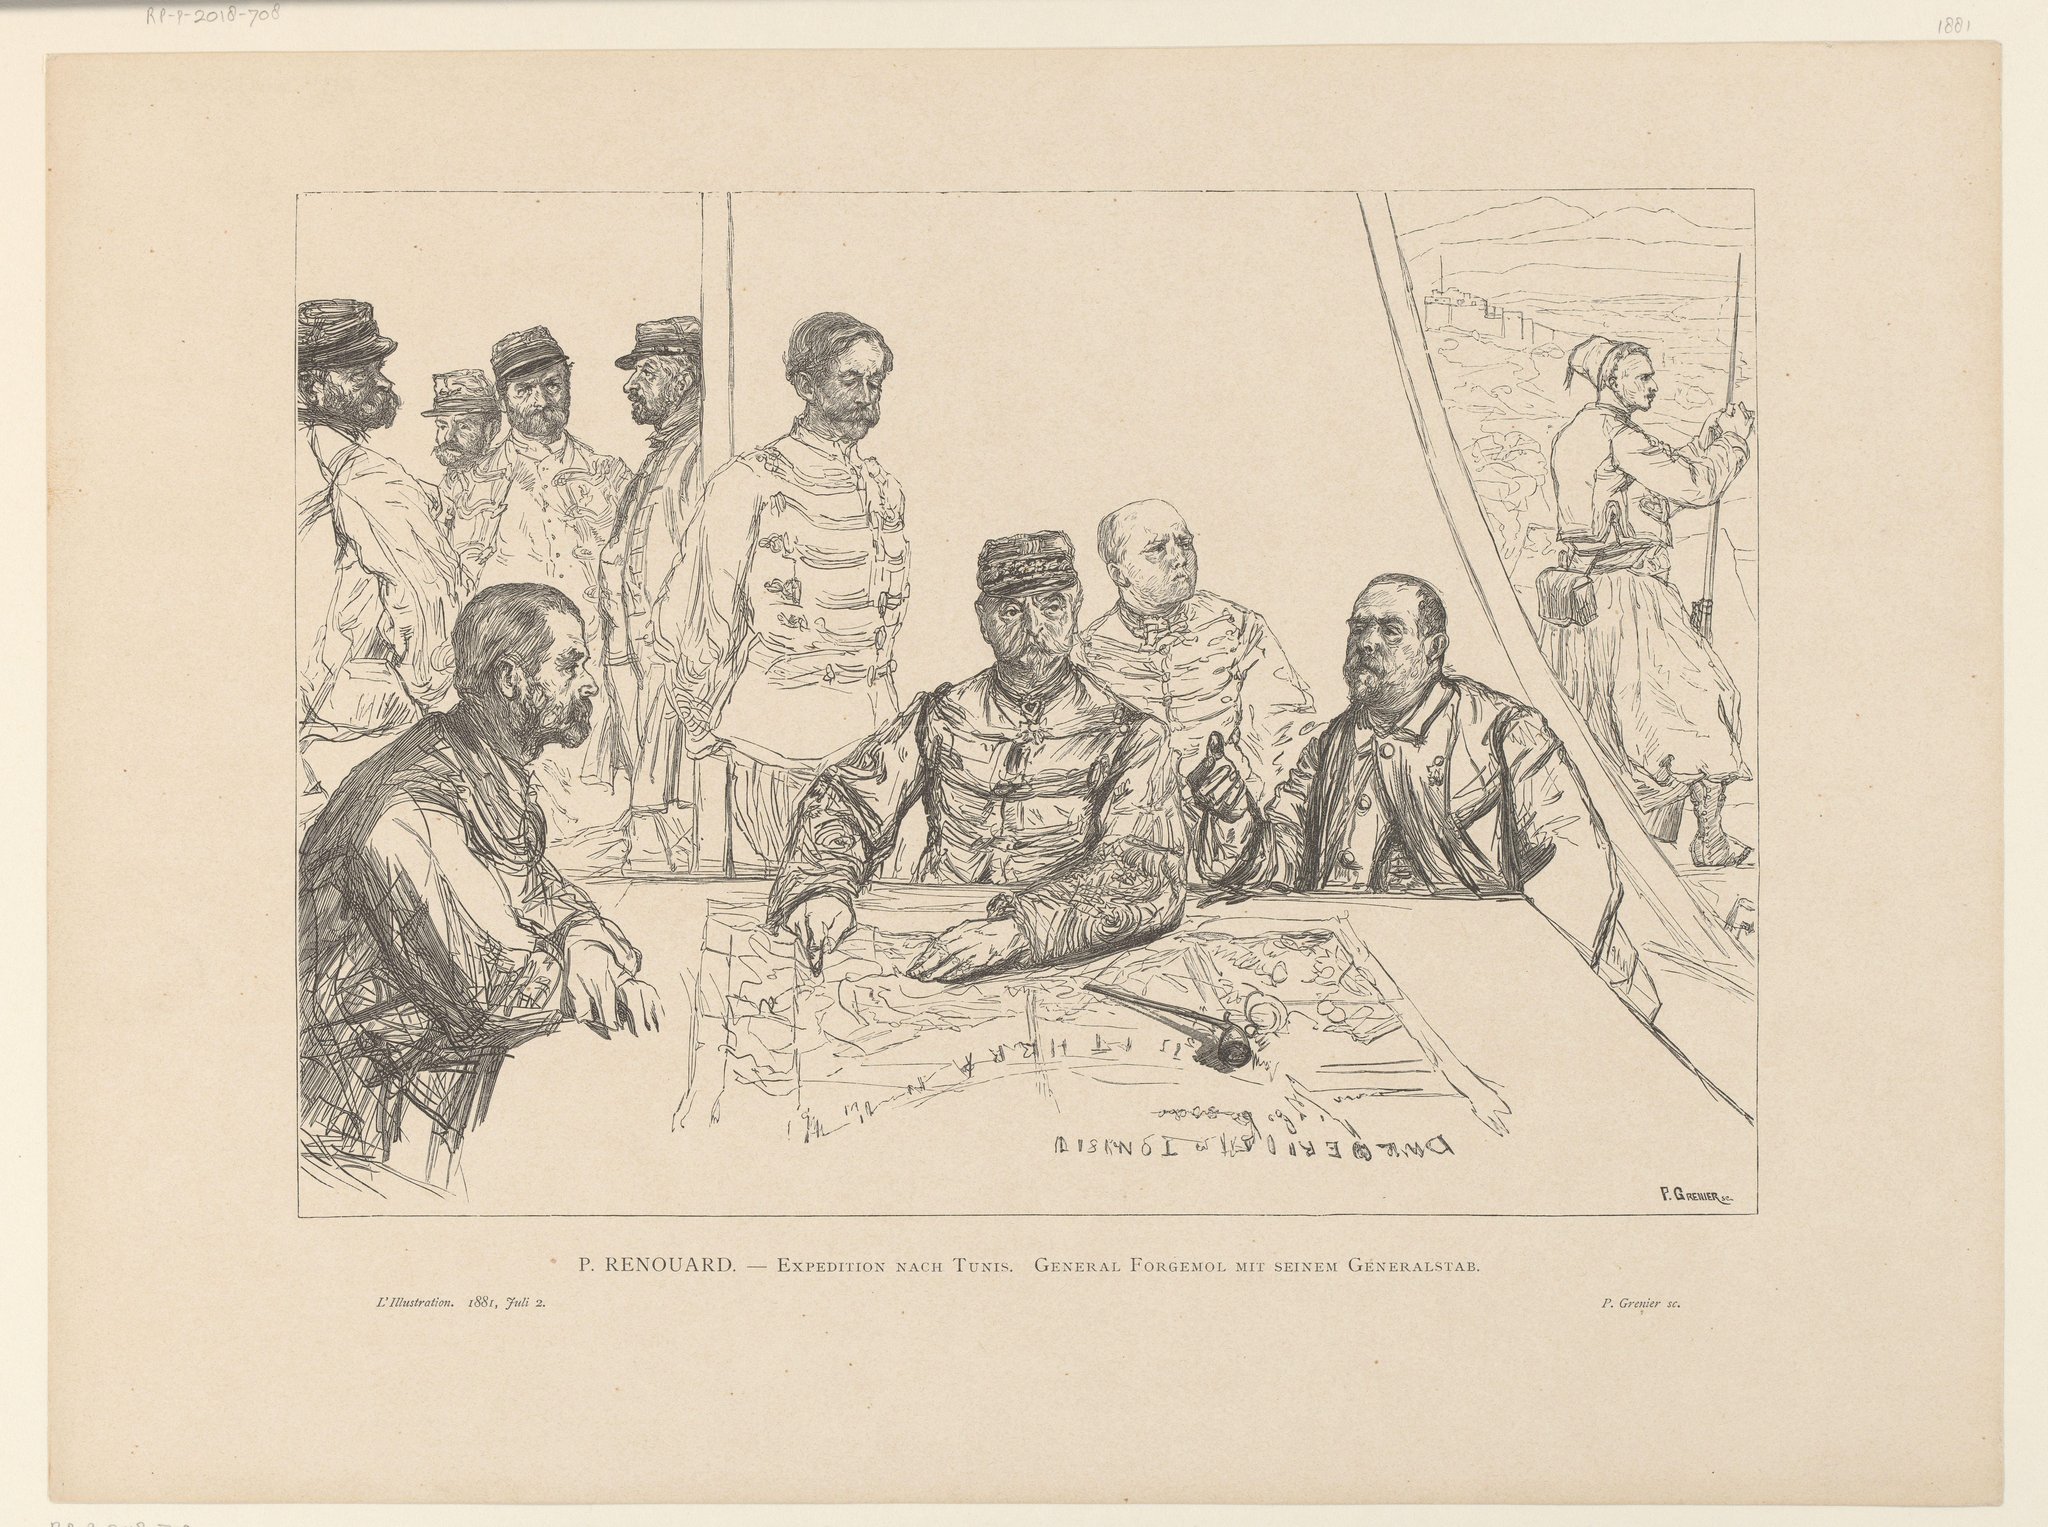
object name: book illustration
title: Expedition nach Tunis. General Forgemol mit seinem Generalstab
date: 1881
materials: paper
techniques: engraving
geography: france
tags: commander-in-chief, general, marshal, council of war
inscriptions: collector's mark: Lugt 3937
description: Franse militaire expeditie in Tunesië onder bevel van generaal Léonard-Léopold Forgemol de Bostquénard, 1881. Beraadslagingen in een tent tussen militaire staf.